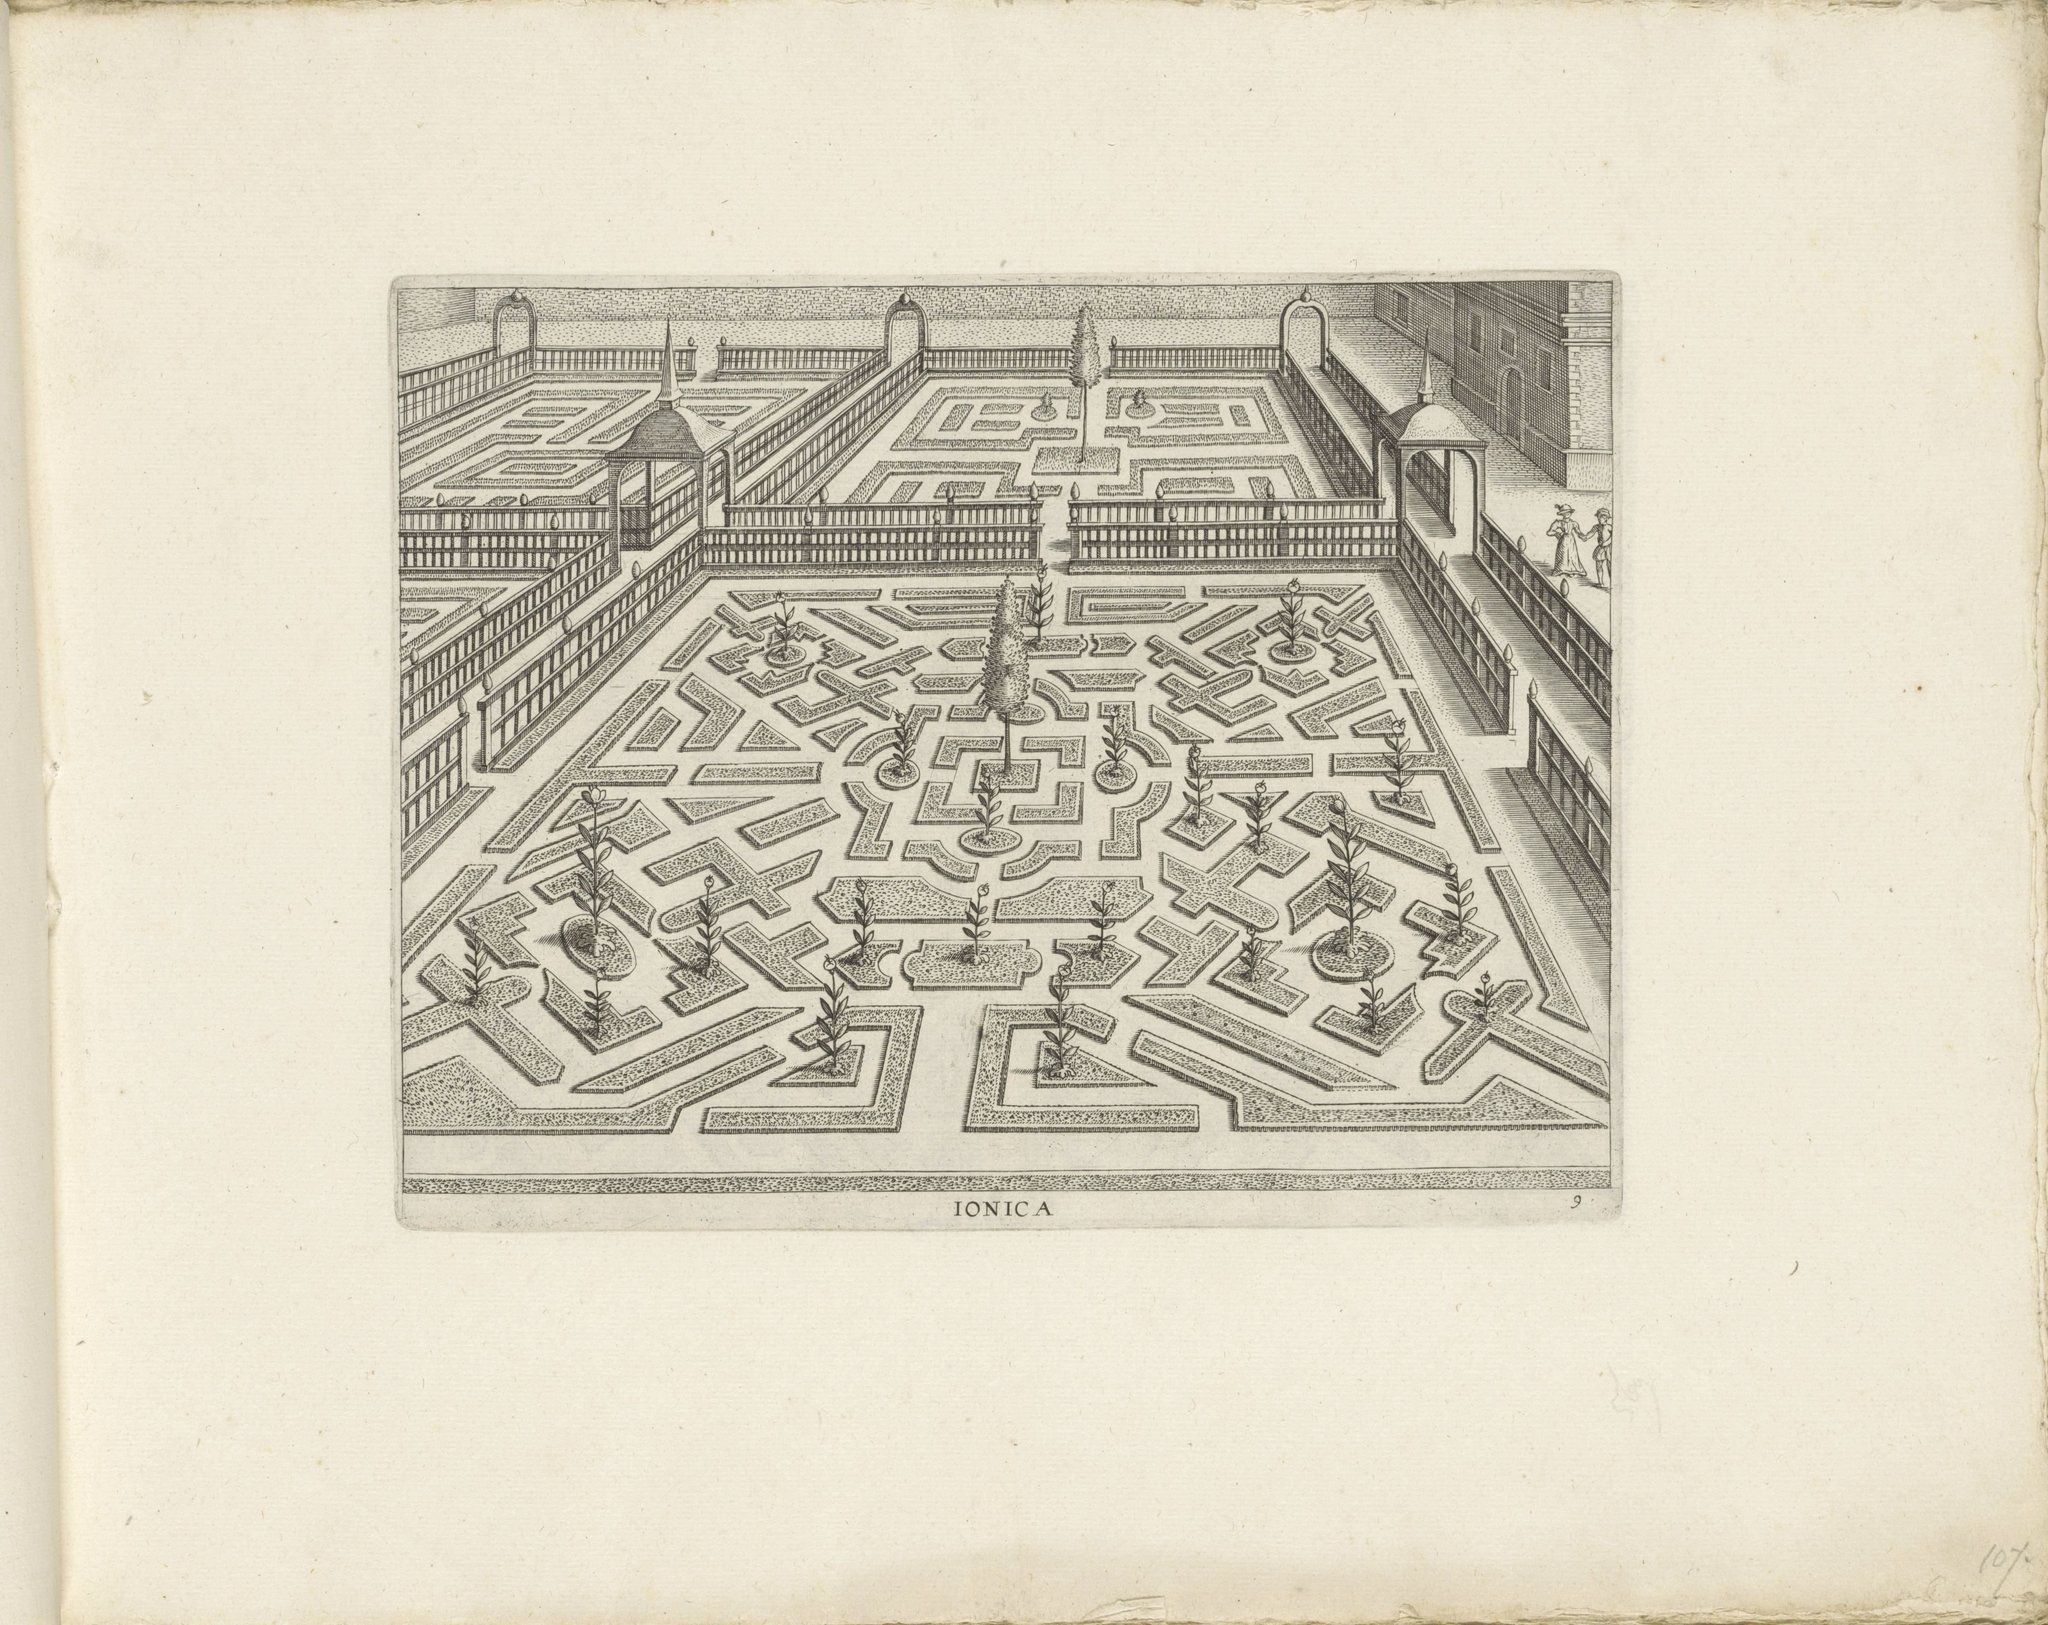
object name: print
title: Tuinontwerpen geassocieerd met de Dorische, Ionische en Korinthische bouworden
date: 1583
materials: paper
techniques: etching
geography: antwerp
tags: garden, french or architectonic garden; formal garden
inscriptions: collector's mark: Lugt 2228, collector's mark: Lugt 2760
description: De serie ‘Hortorum Viridariorumque’ van Vredeman de Vries (Hollstein Dutch 470-490) is in deze editie van de serie door uitgever Joannes Galle ( en eerder door zijn voorganger Theodoor Galle) aangevuld met de serie ‘Tuinen’ van Vredeman de Vries (Hollstein Dutch 508-515) en met twee prenten van Pieter van der Borcht (I) (New Hollstein Dutch 161-162). De prenten zijn genummerd: 1-30. Origineel hoort bij deze editie van de serie, uitgegeven door Joannes Galle, nog een prent van Van der Borcht met nummer 31, maar deze prent ontbreekt in deze serie in de collectie van het Rijksmuseum.